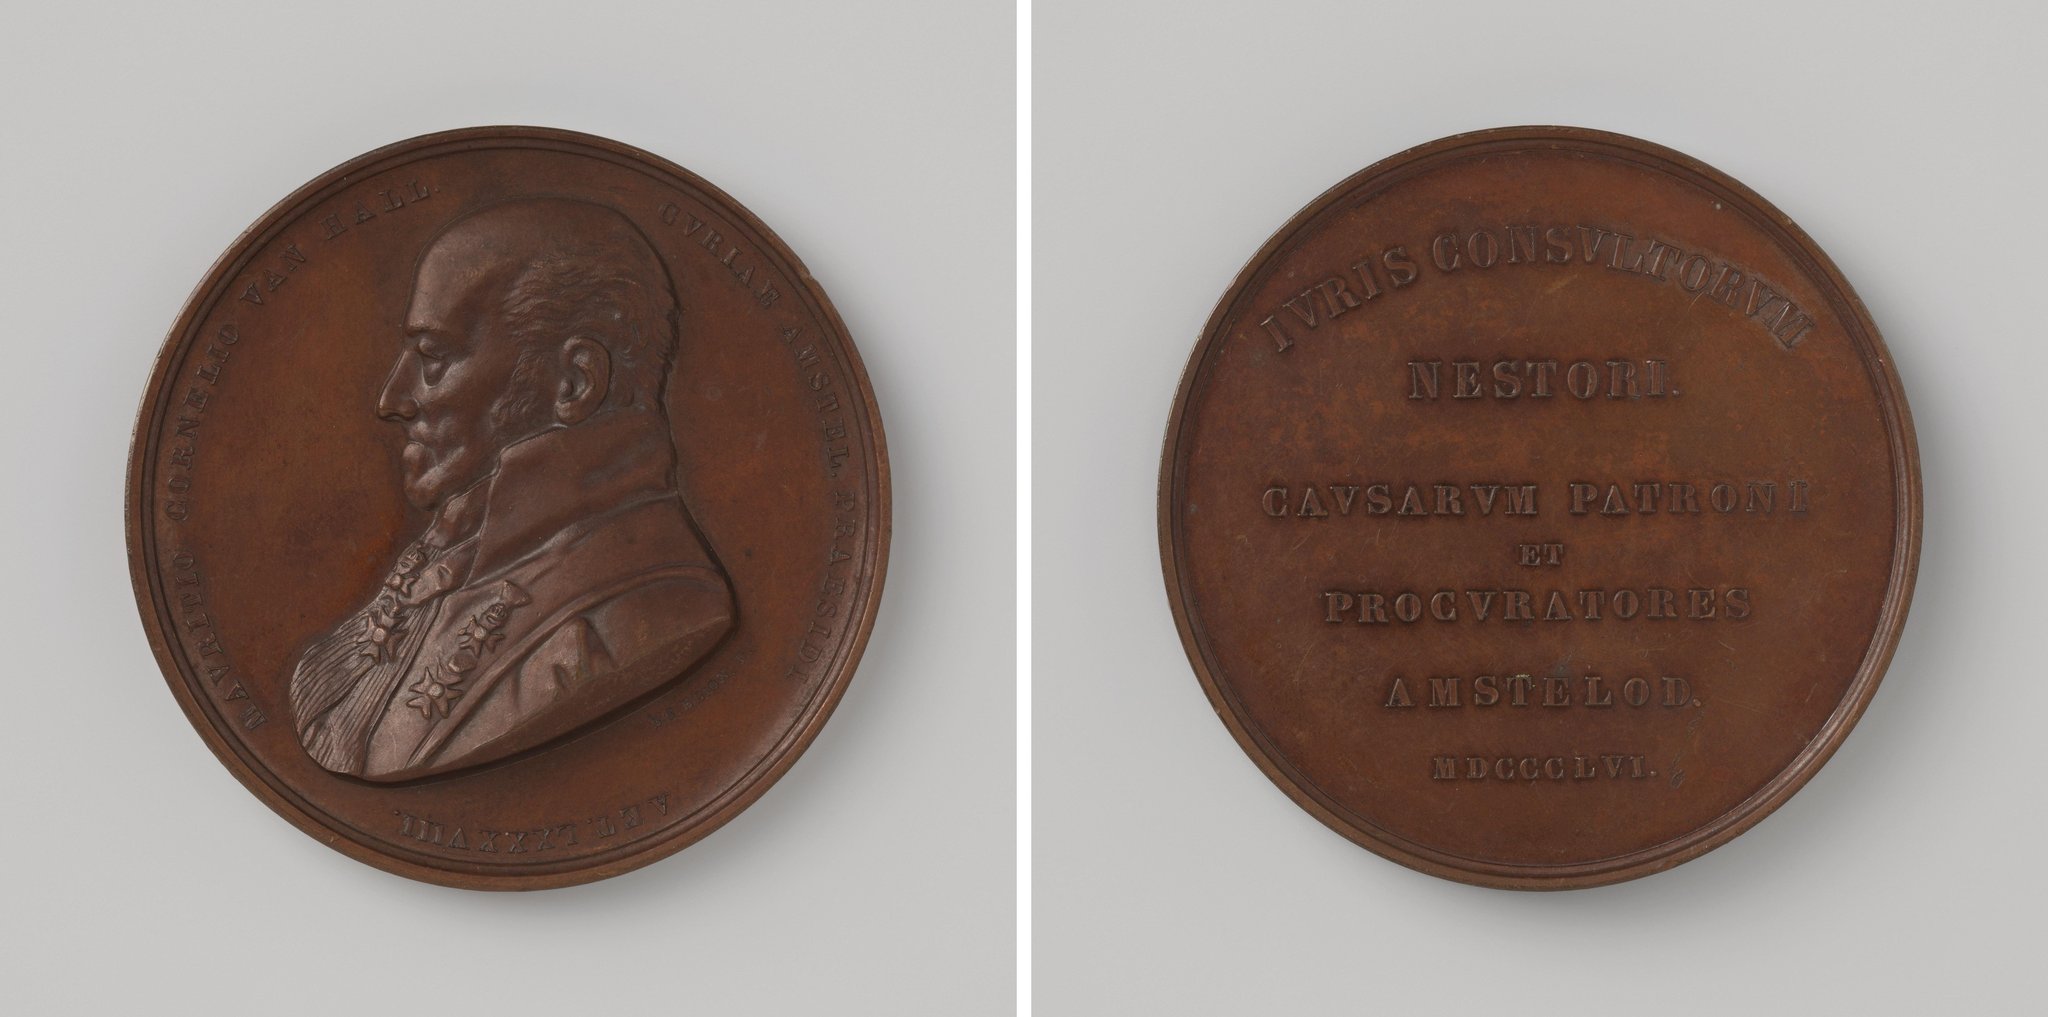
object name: history medal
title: Vijfenzeventigste verjaardag van Maurits Cornelis van Hall, voorzitter van de arrondissementsrechtbank te Amsterdam 1856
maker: samuel cohen elion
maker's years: 1815-1880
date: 1856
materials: bronze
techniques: striking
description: Bronzen penning, op de voorzijde het borstbeeld van Van Hall naar links met omschrift, op de keerzijde zeven regels tekst.